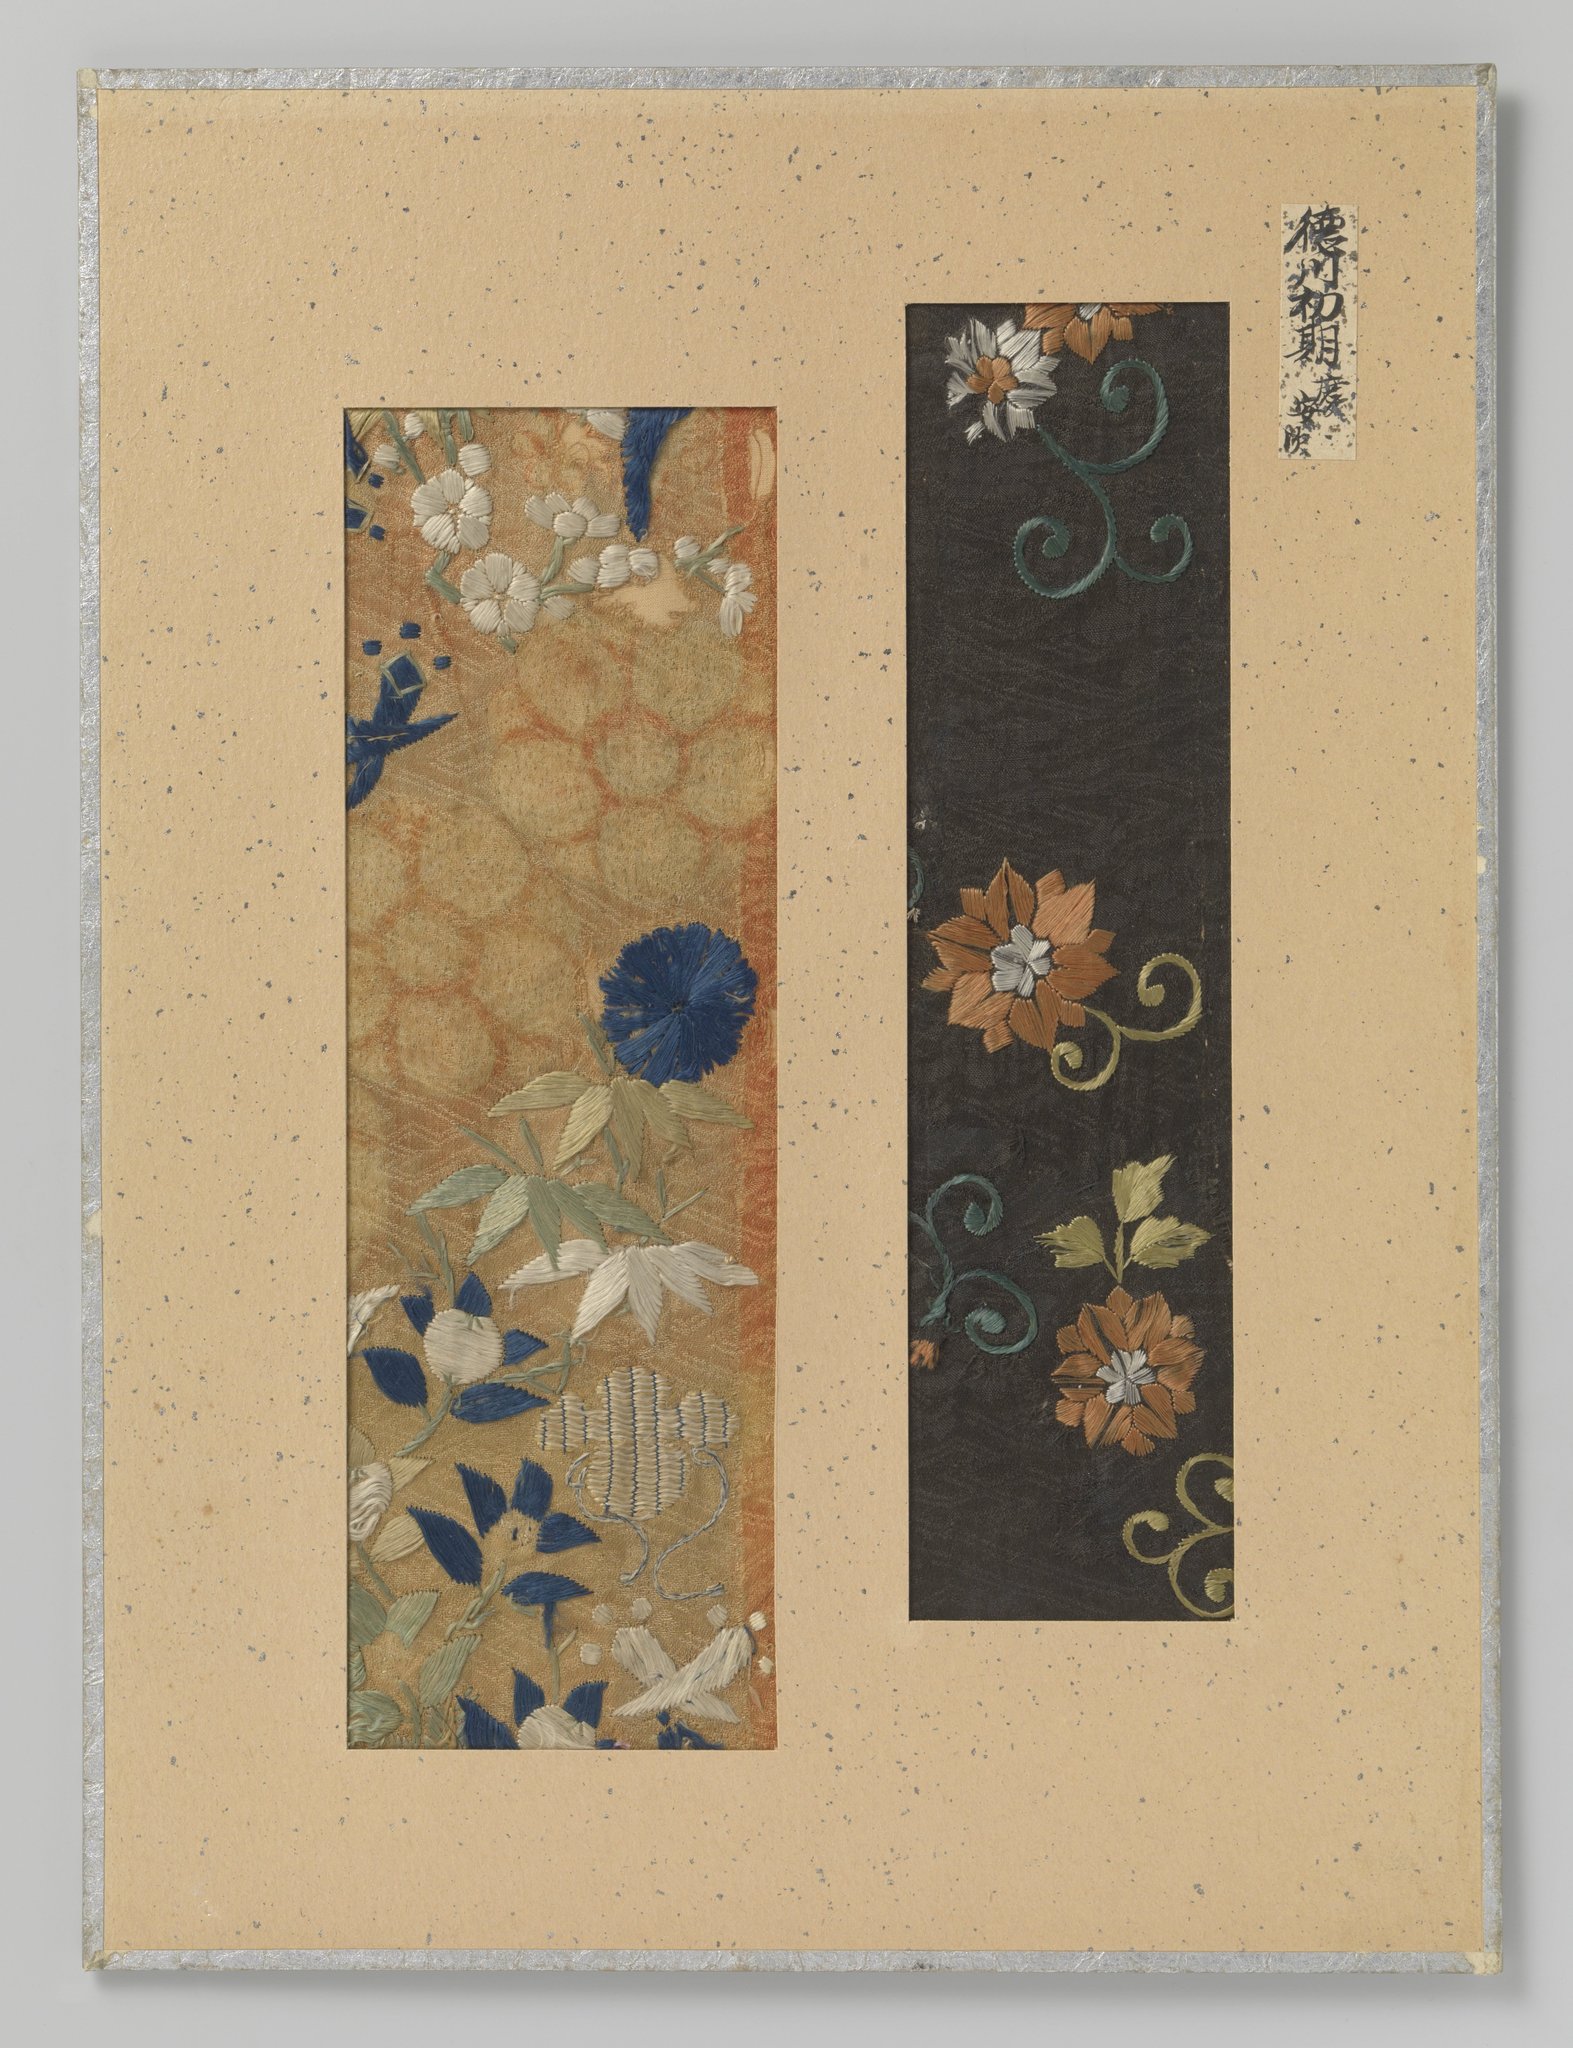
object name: fragment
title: Twee fragmenten textiel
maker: Anonymous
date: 1648-1652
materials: silk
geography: japan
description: Textielfragmenten, twee, borduursel op zijde.